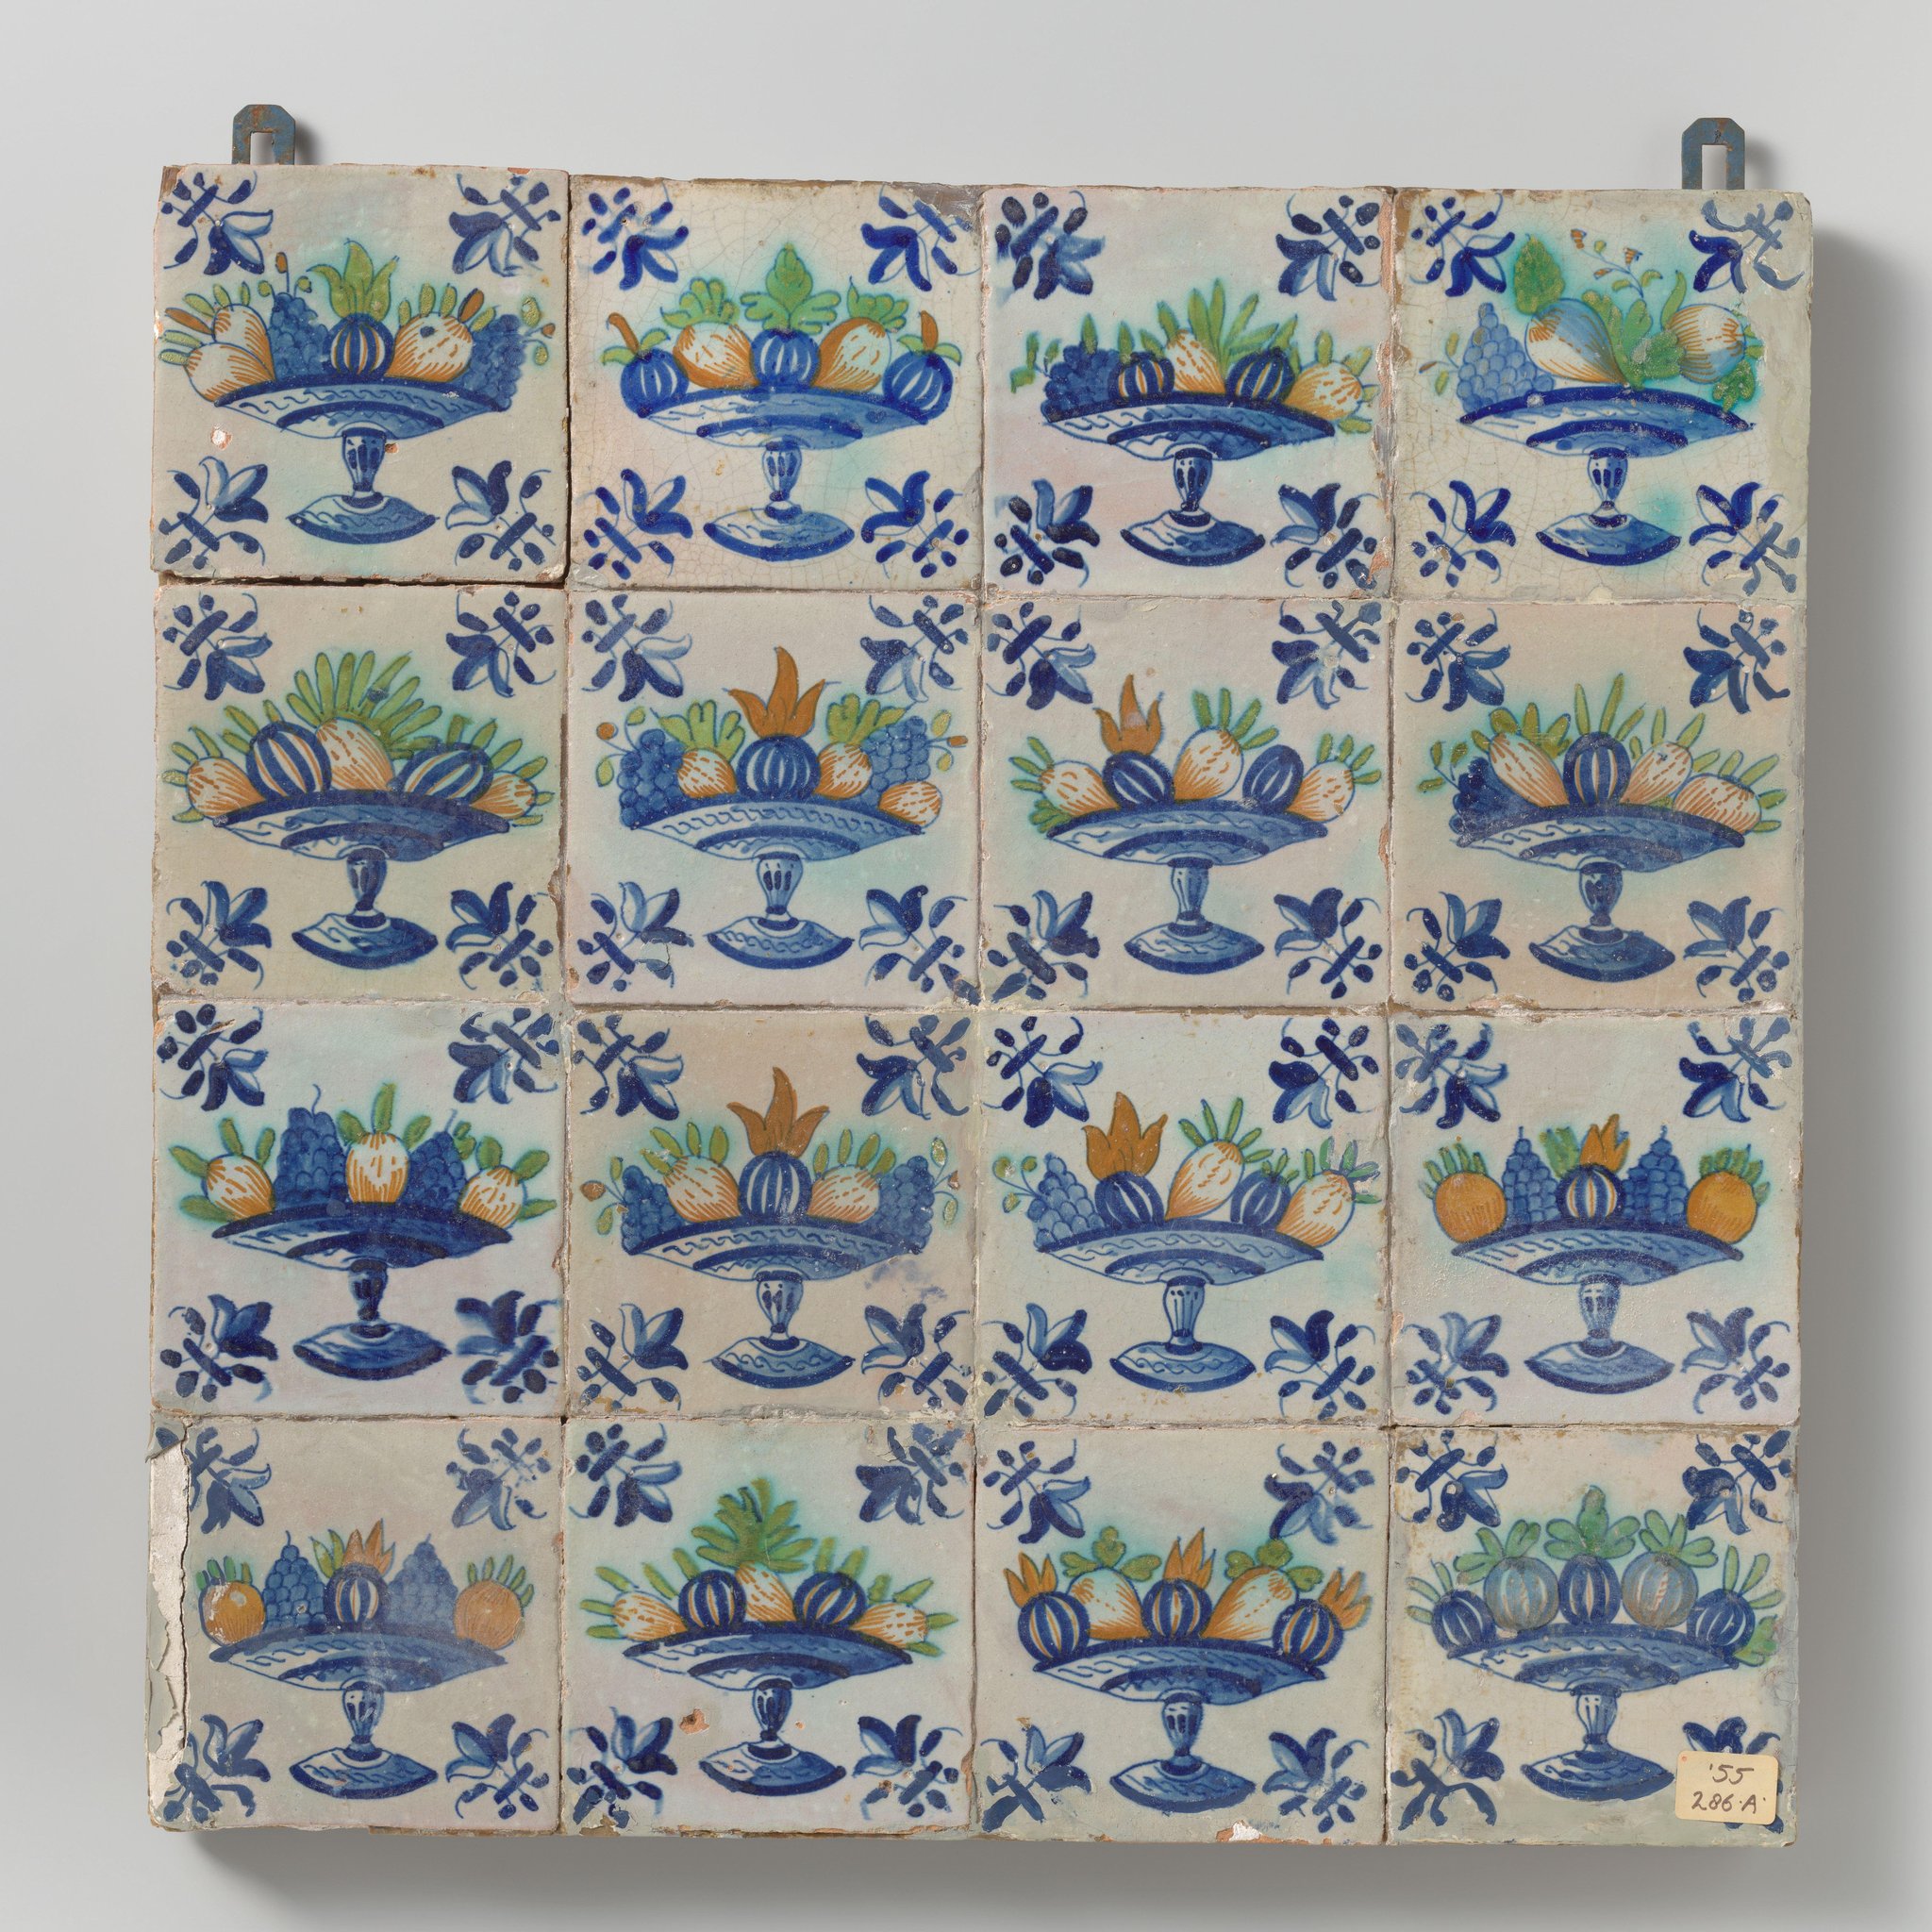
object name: tegelveld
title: Tegel met fruitschaal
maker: Anonymous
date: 1640-1660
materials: earthenware, glaze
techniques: maiolica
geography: netherlands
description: Onderdeel van een veld van zestien tegels (4 x 4), zie BK-1955-286-A.